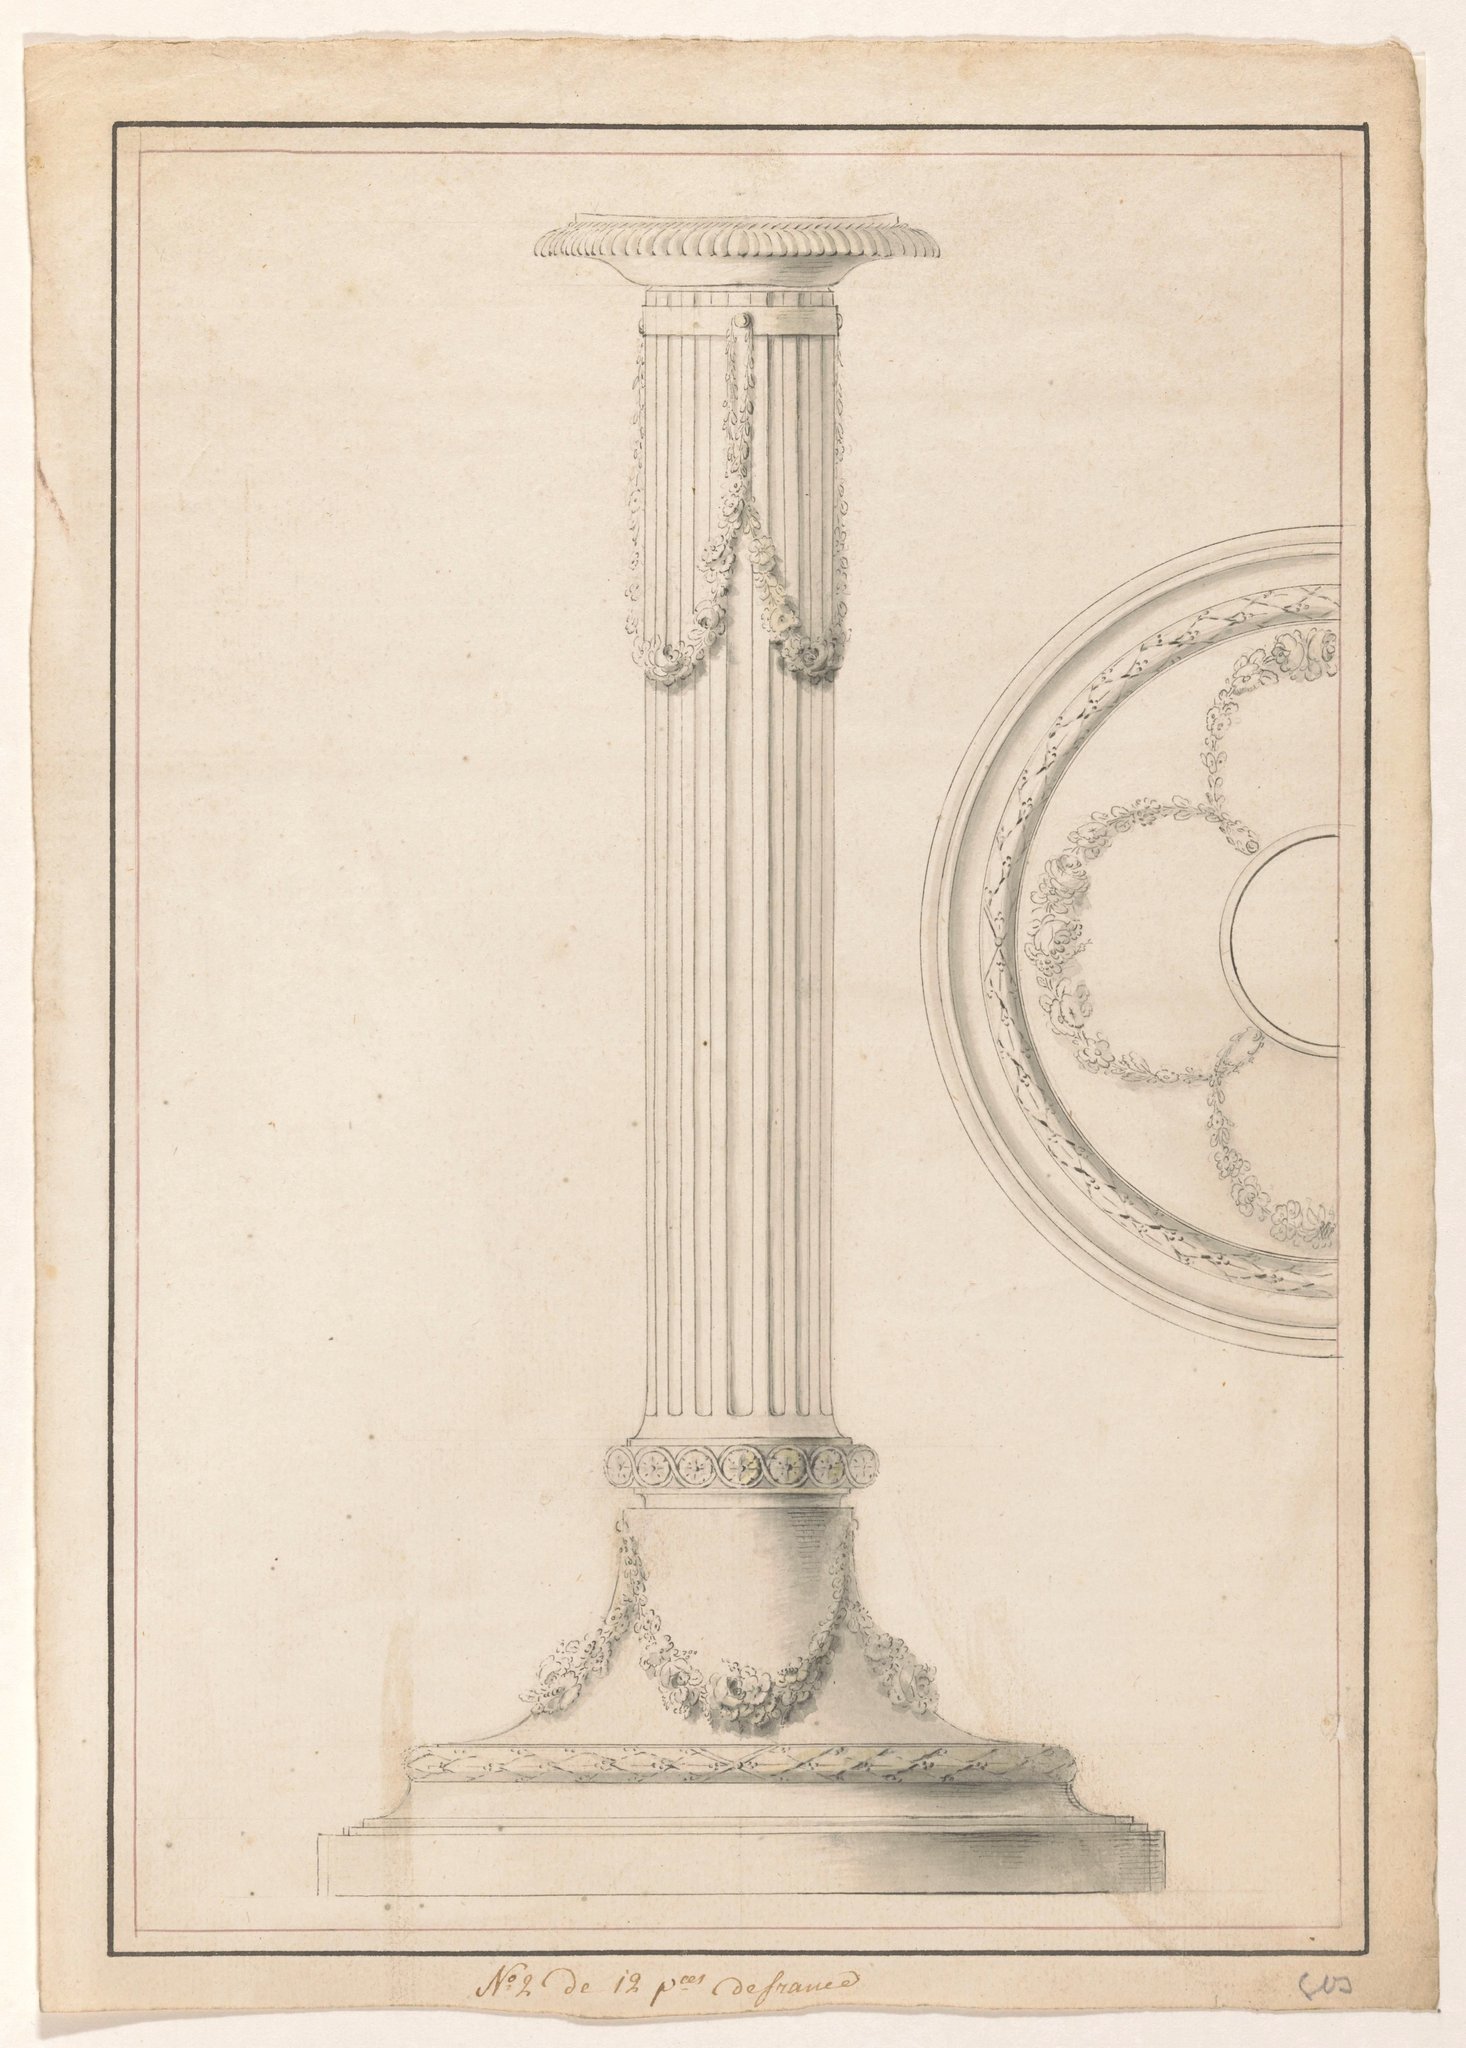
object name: design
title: Ontwerptekening van een kandelaar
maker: Anonymous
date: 1700-1799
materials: ink, paper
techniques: brush, pen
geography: france